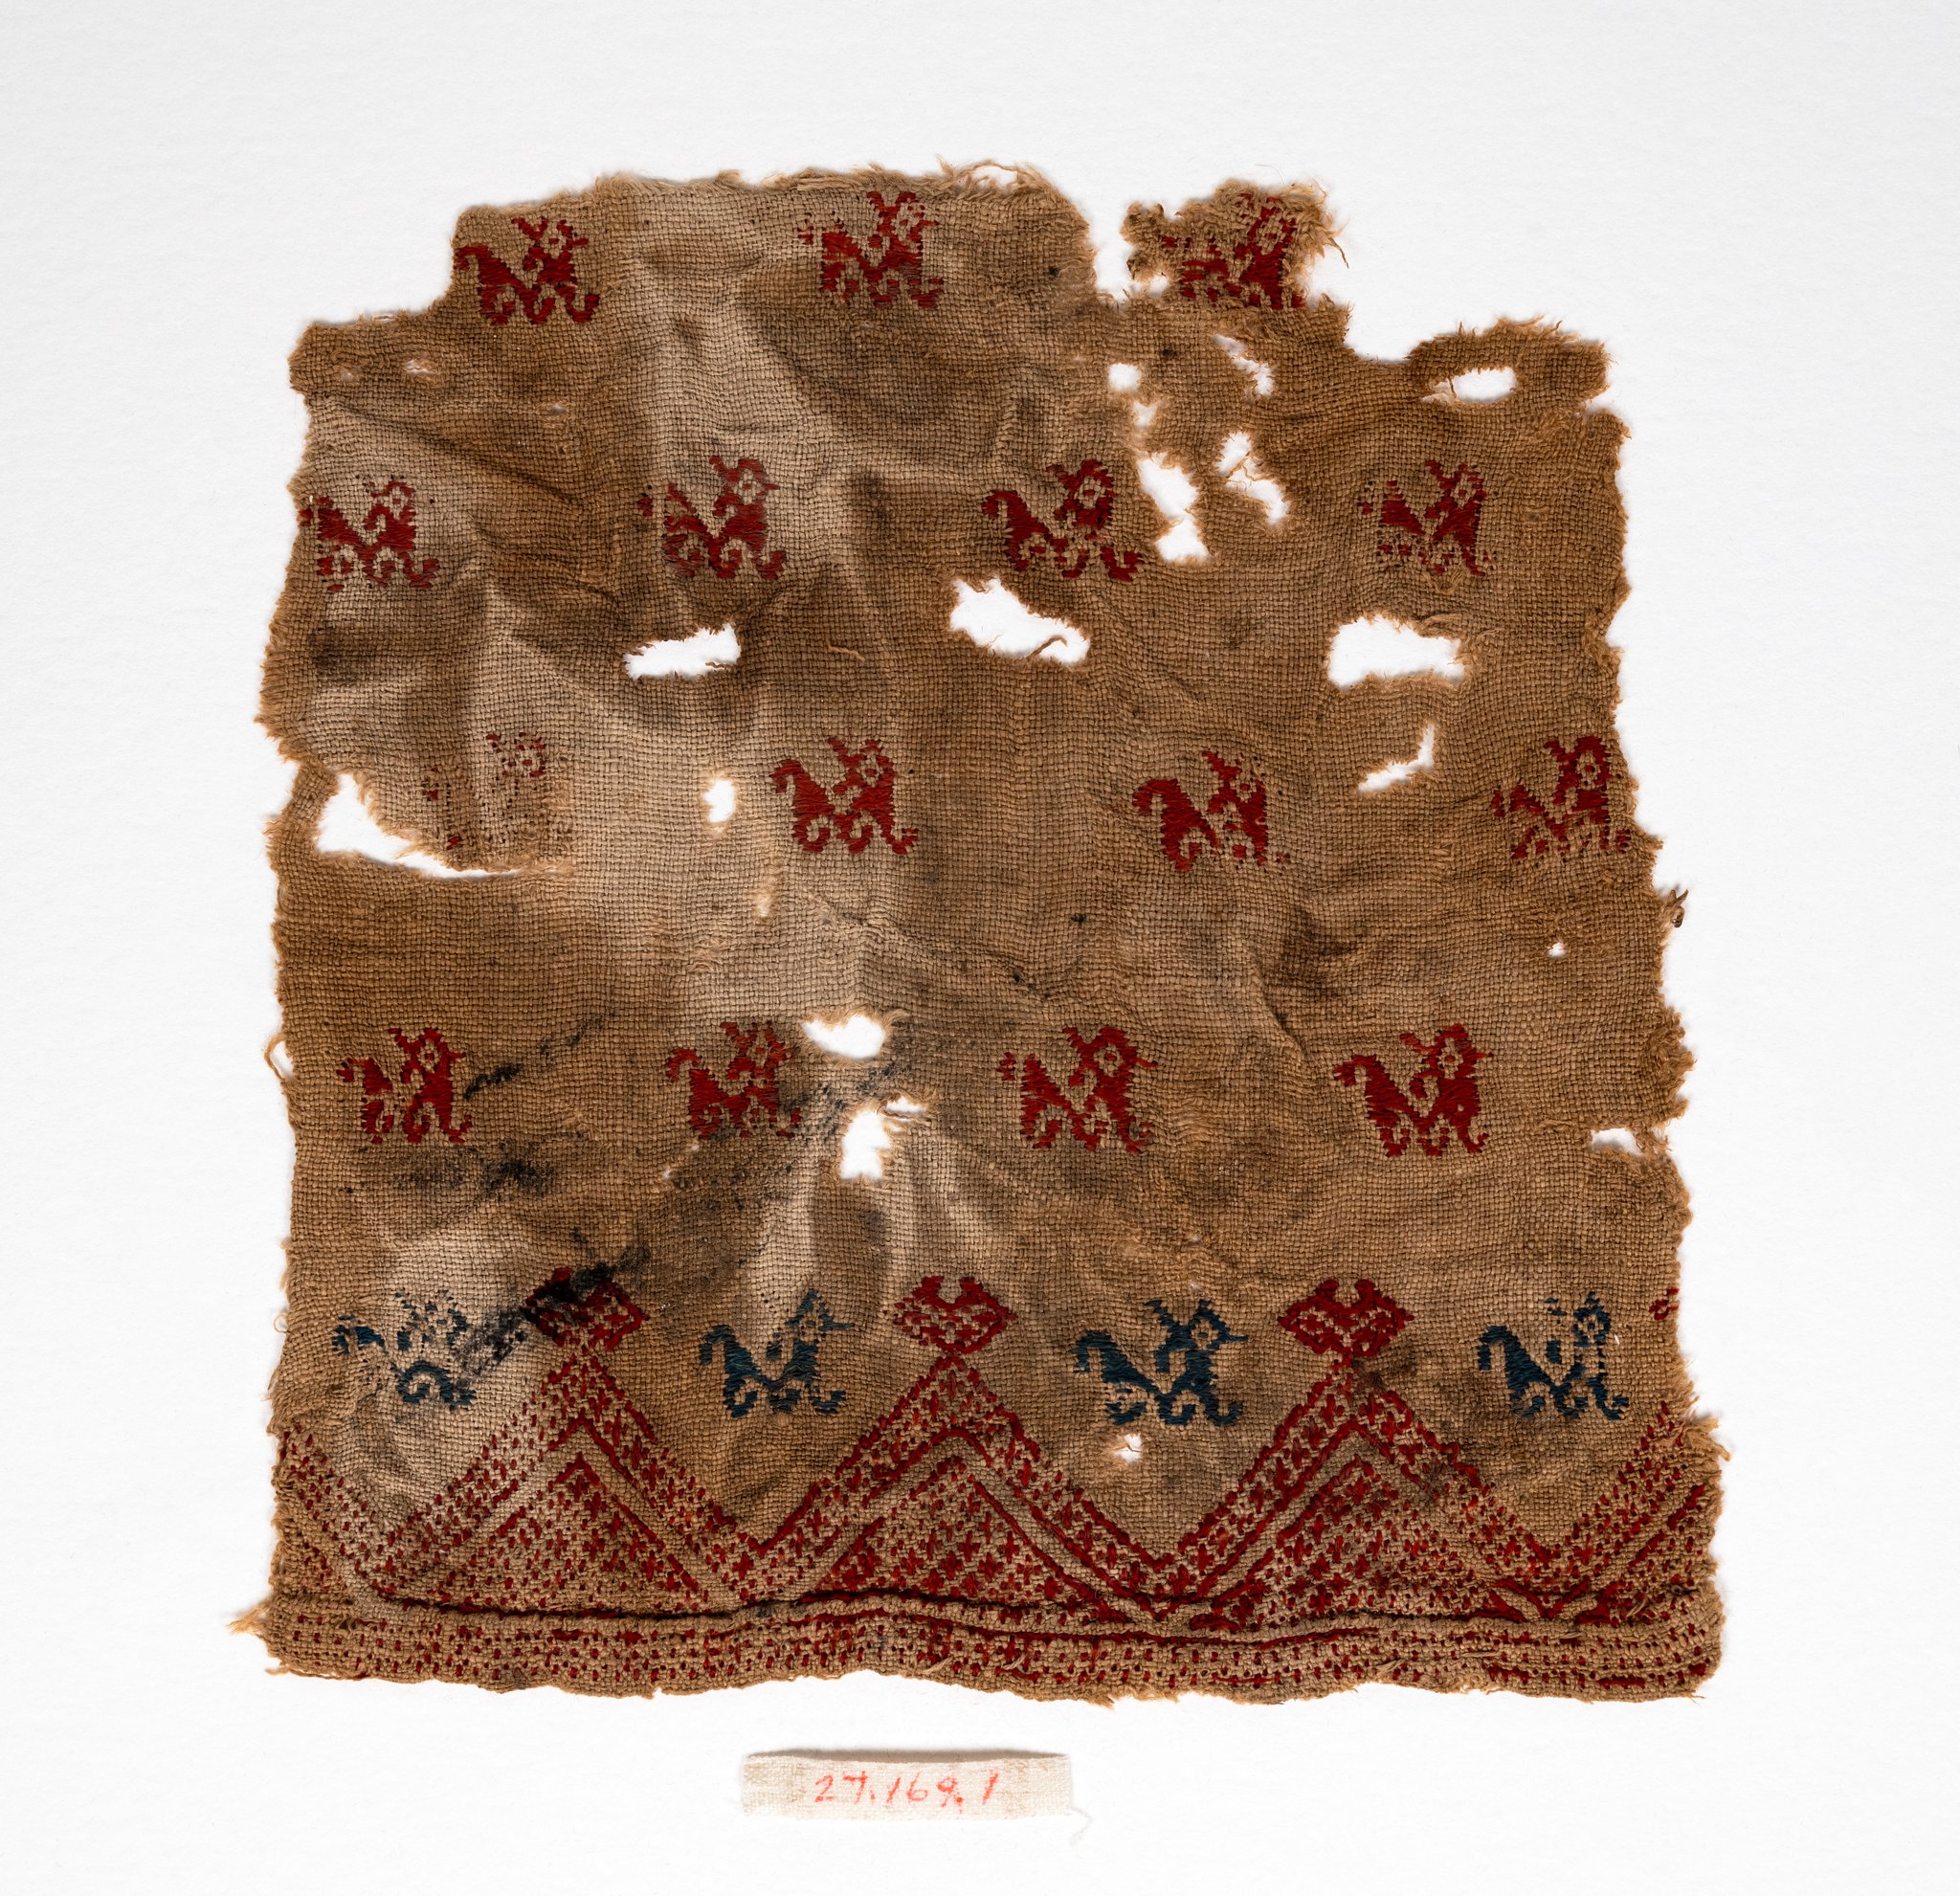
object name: textile fragment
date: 1201-1400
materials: linen, silk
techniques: embroidery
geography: egypt